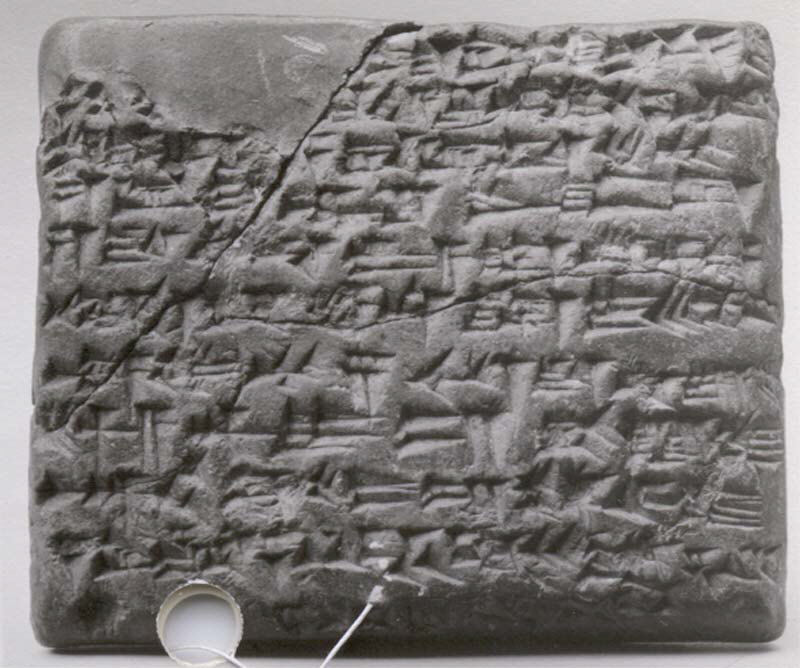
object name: cuneiform tablet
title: Cuneiform tablet impressed with ring seal: promissory note for barley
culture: achaemenid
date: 419 BCE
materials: clay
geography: mesopotamia